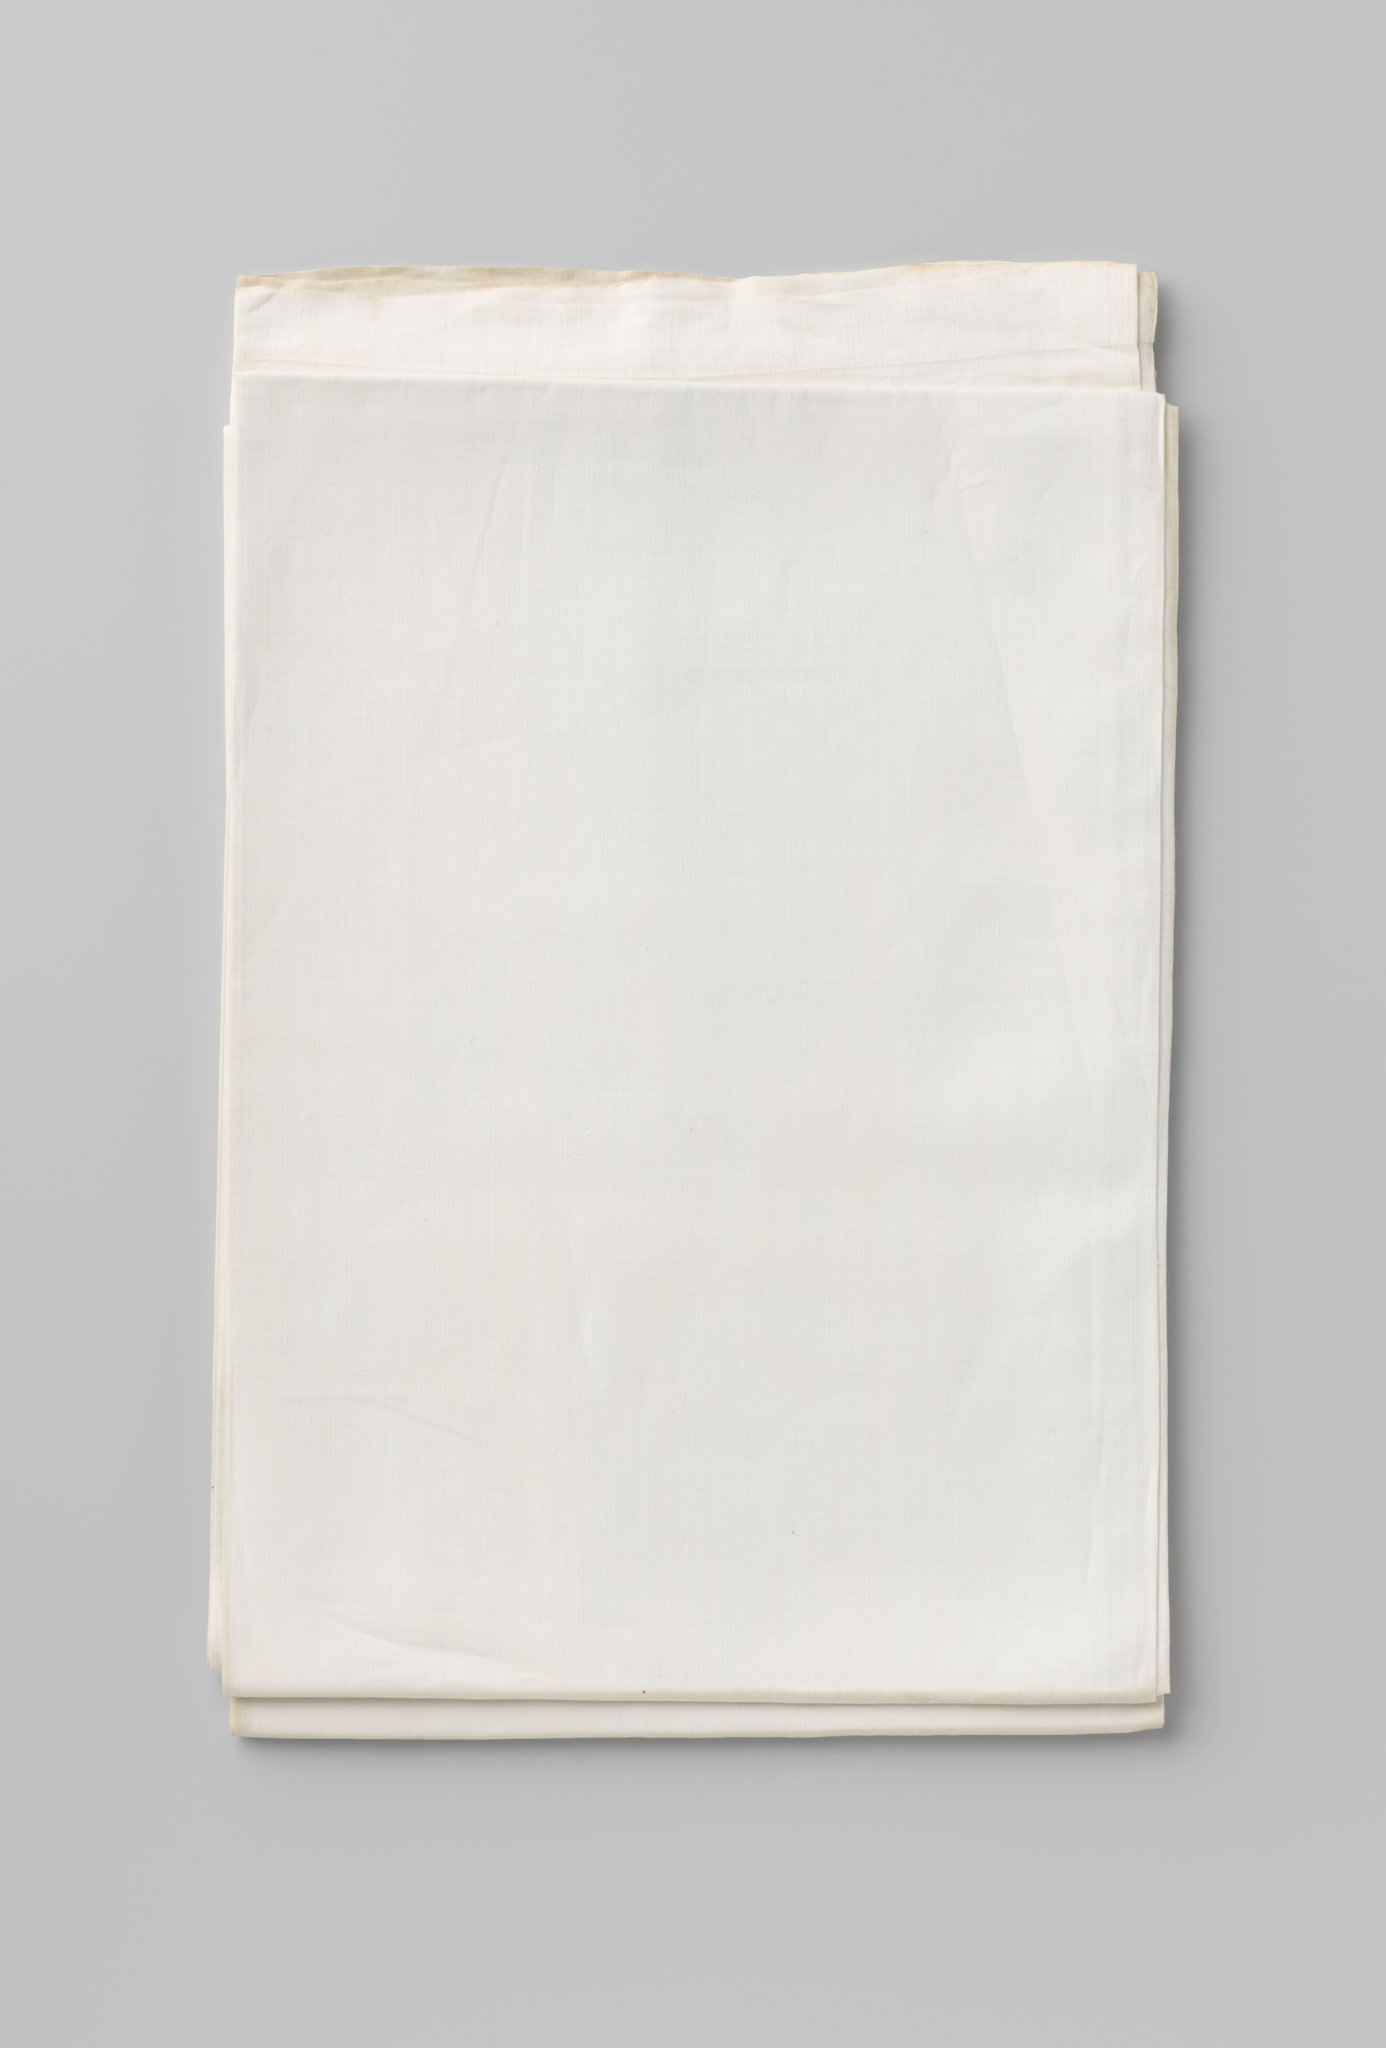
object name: beddenlaken, laken object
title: Laken.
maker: Anonymous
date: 1700-1750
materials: linen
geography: northern netherlands